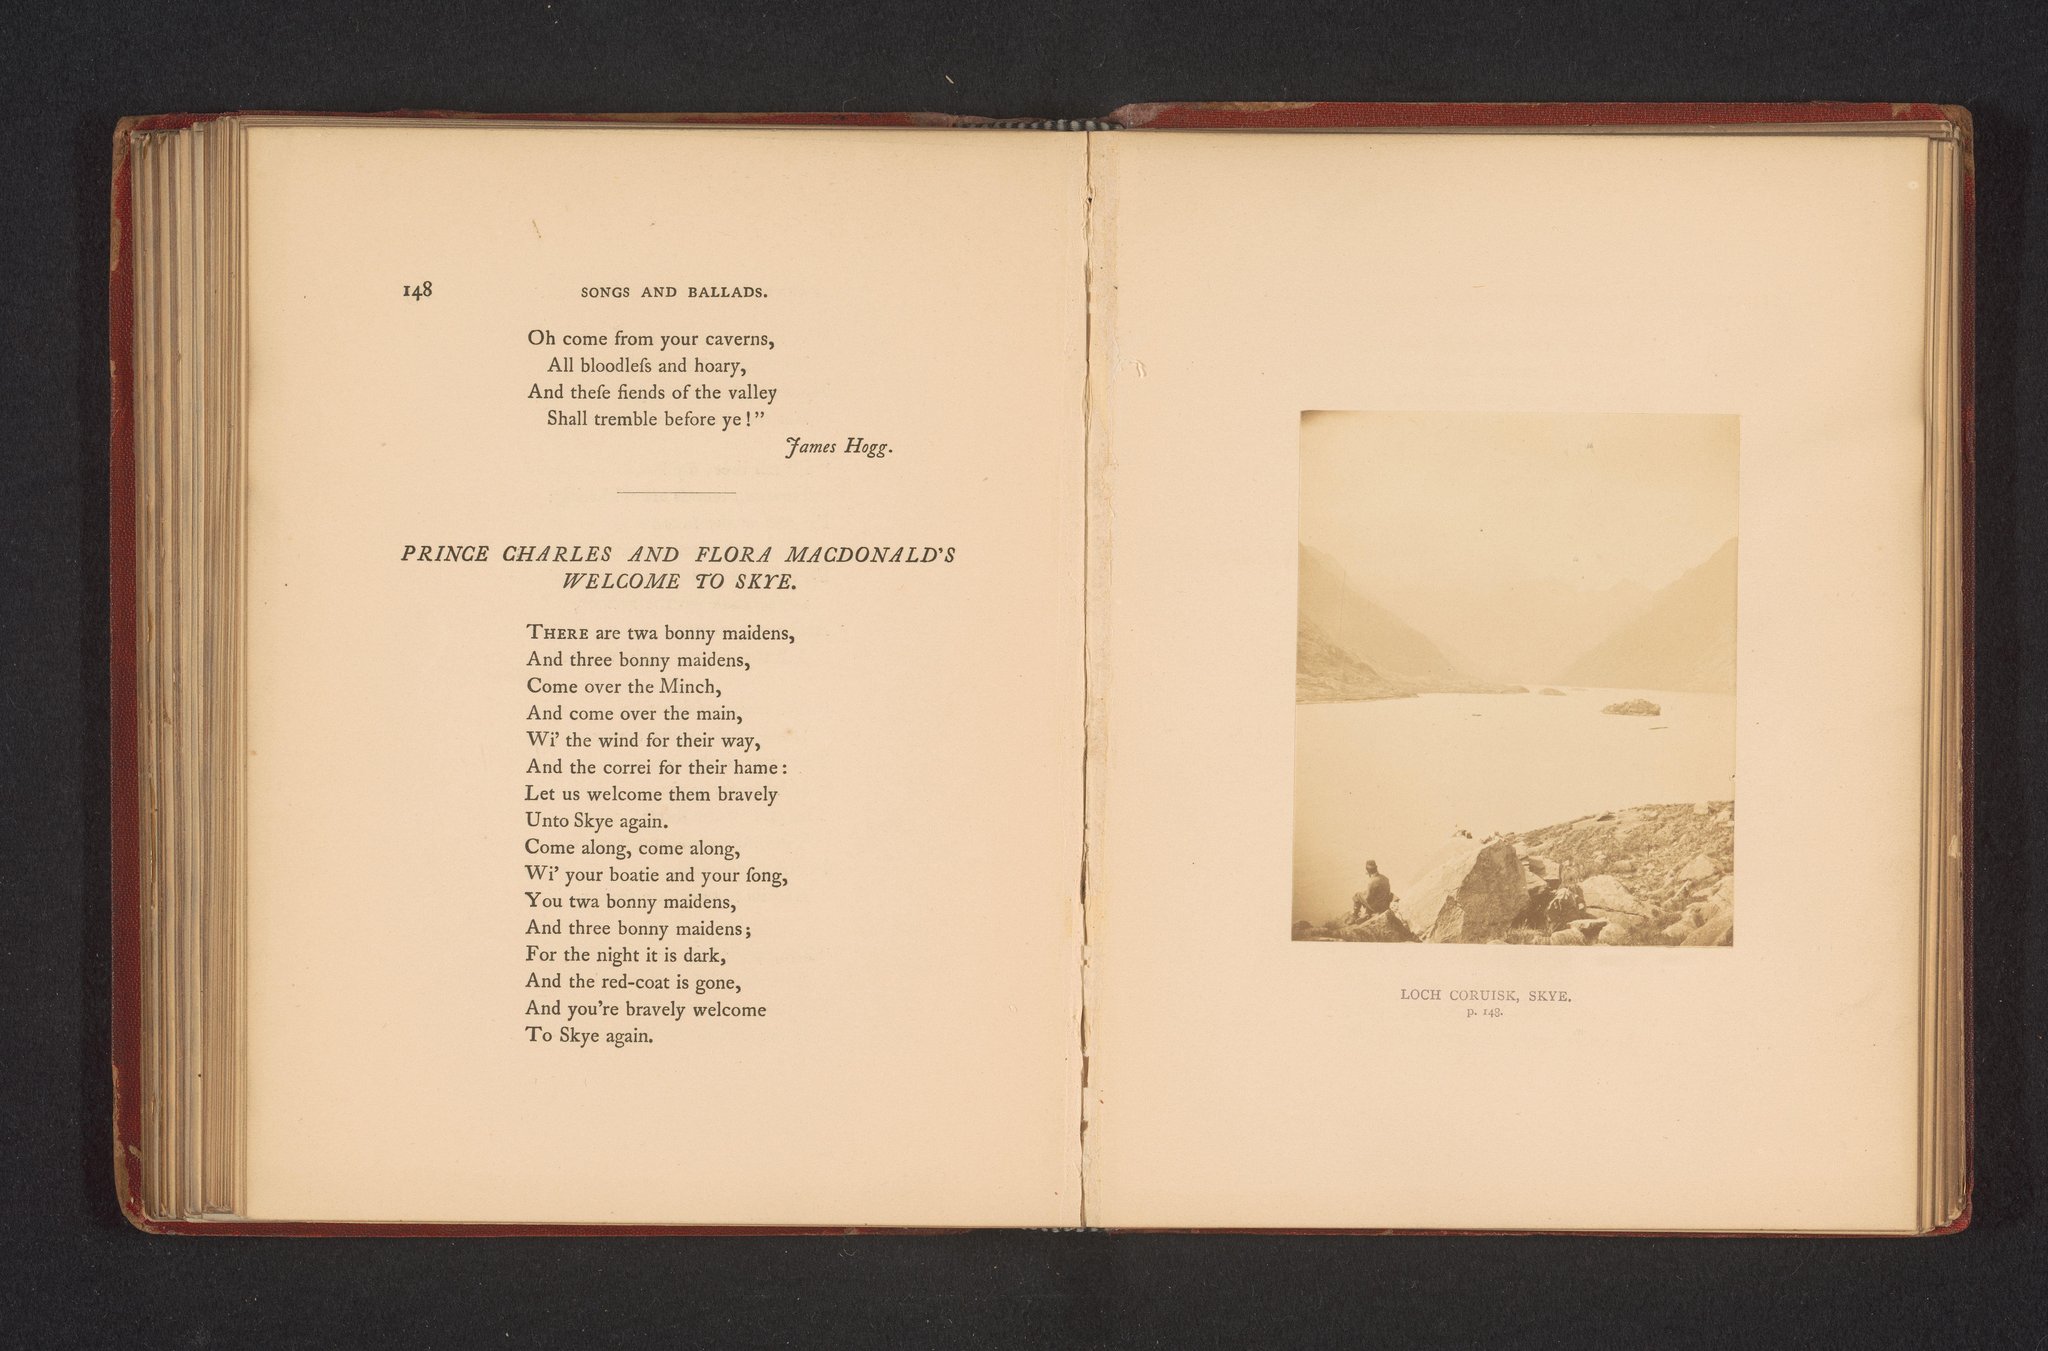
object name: page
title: Loch Coruisk, Skye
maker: stephen thompson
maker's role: fotograaf, schrijver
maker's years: 1831-1893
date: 1863-1868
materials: photographic support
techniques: albumen print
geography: skye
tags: river